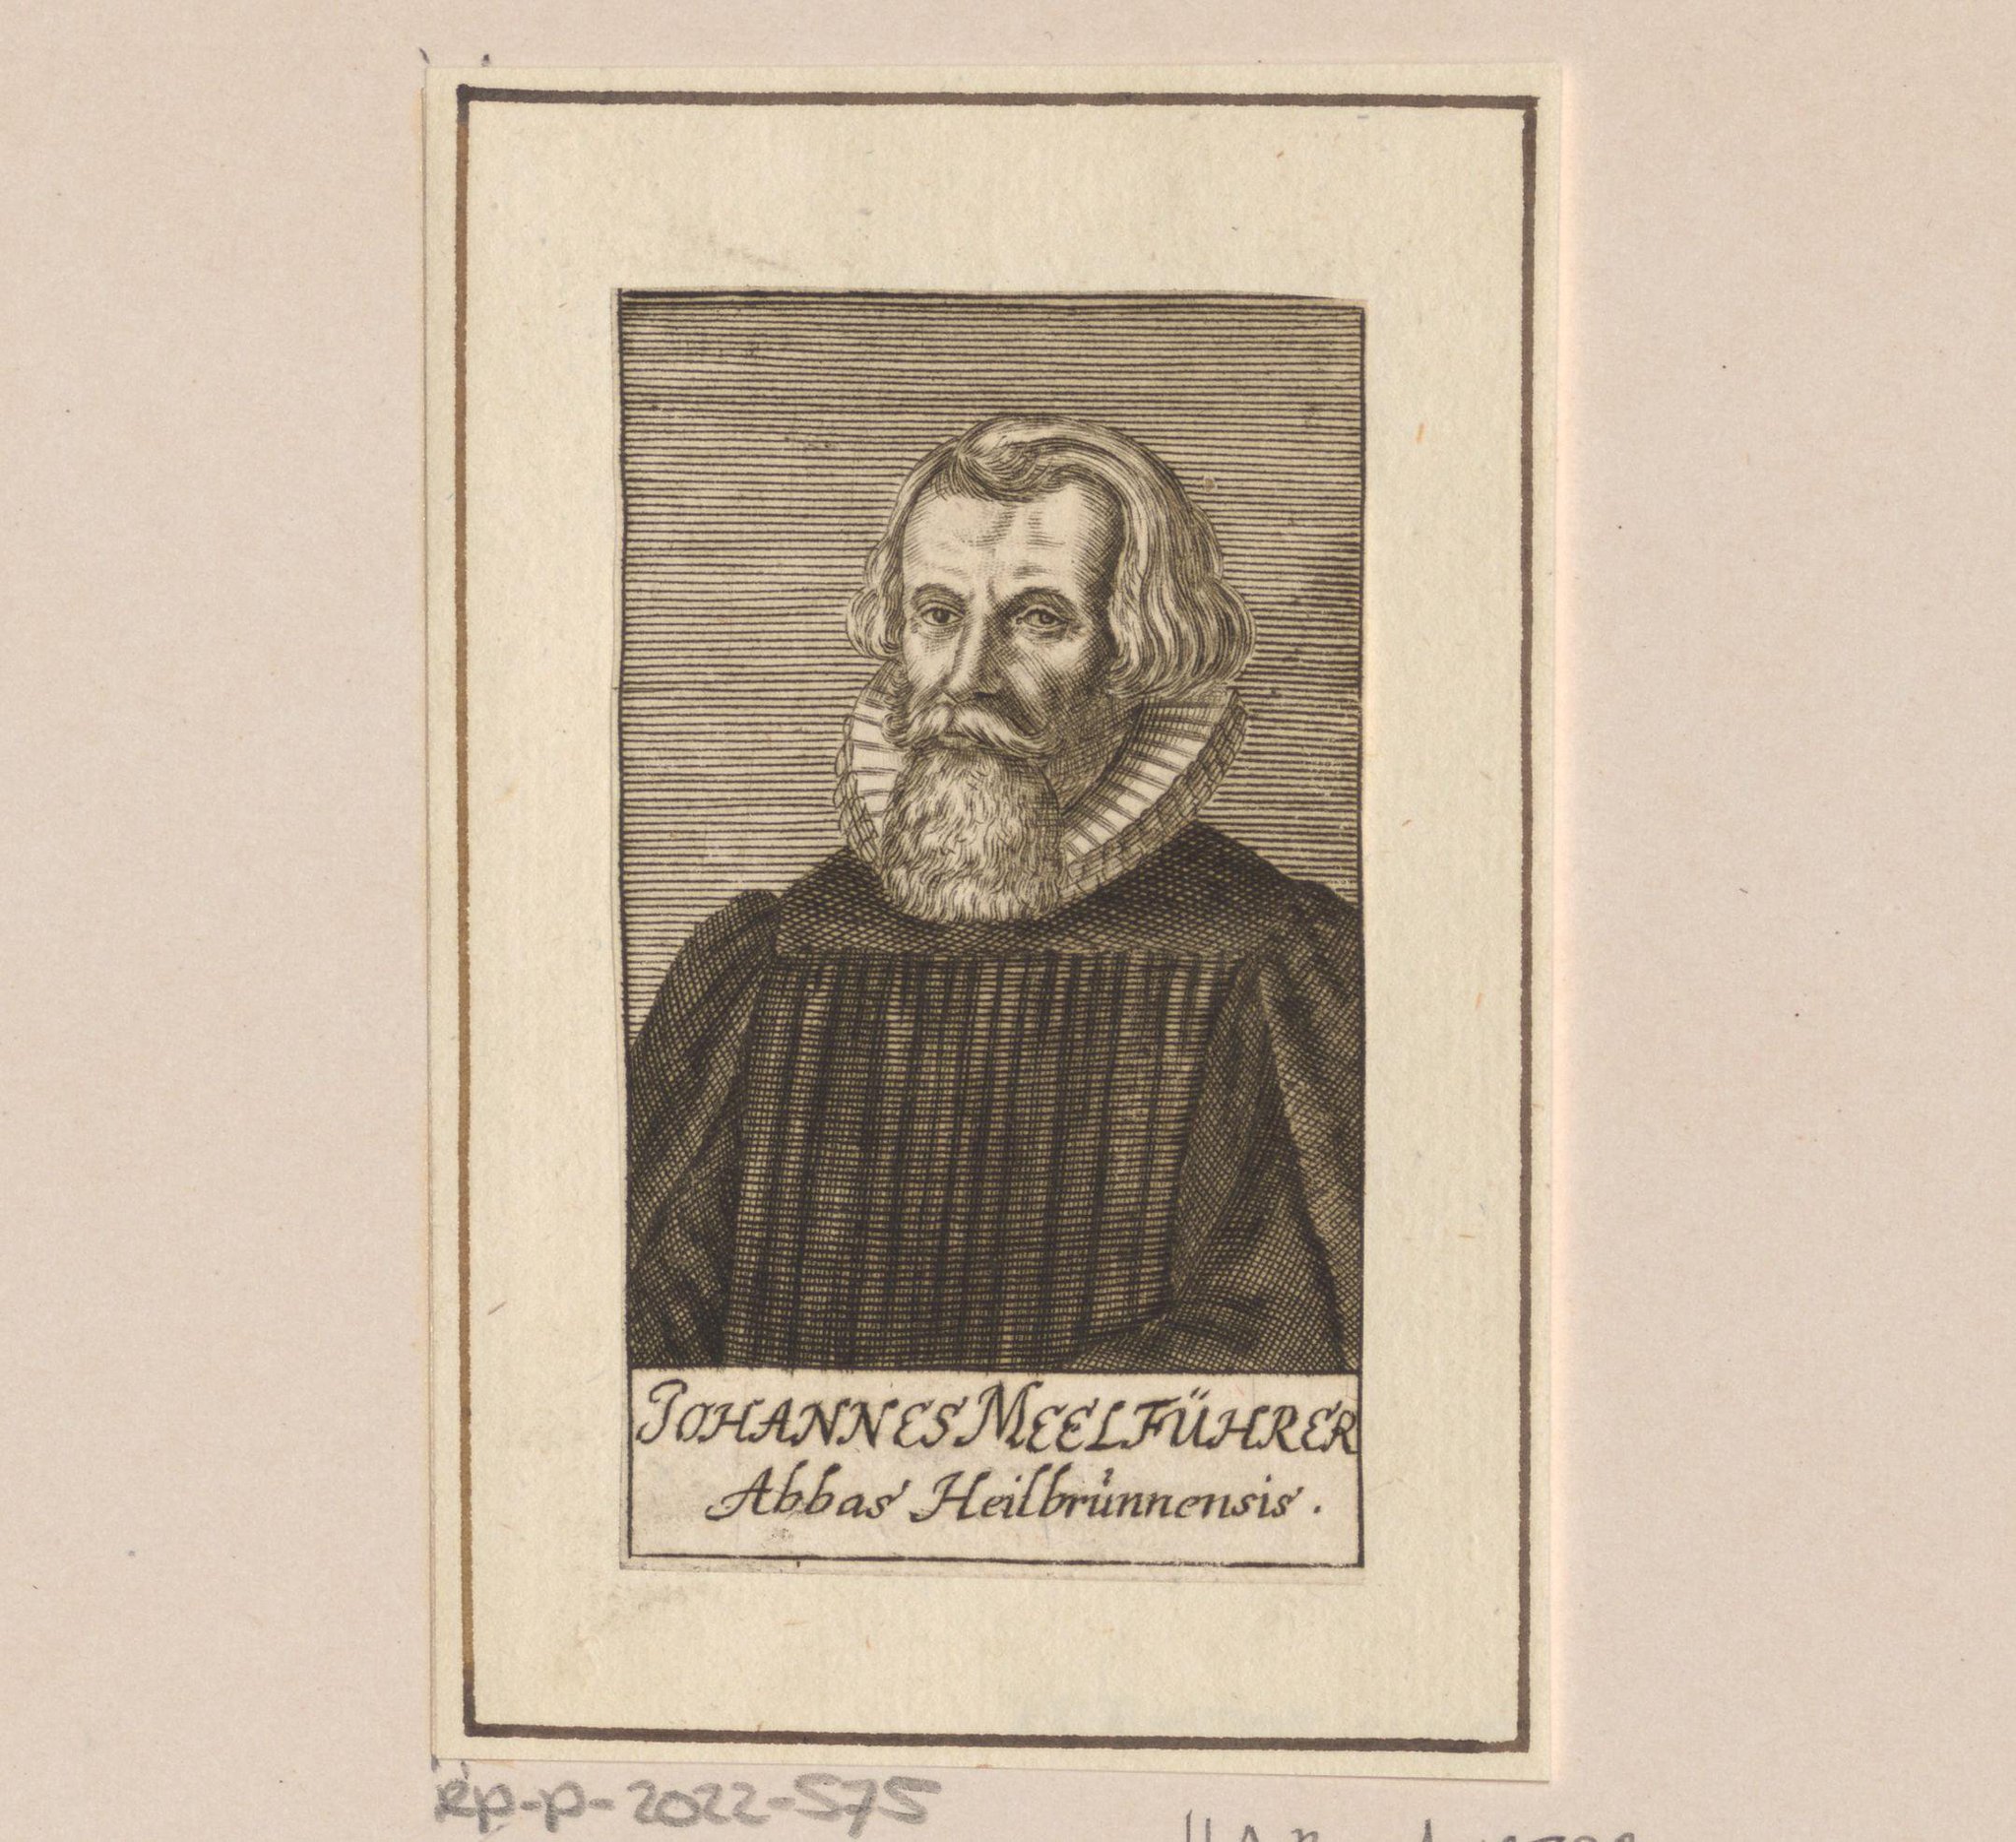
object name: book illustration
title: Portret van Johann Christoph Meelführer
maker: johann azelt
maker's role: print maker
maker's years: 1654-1692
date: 1688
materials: paper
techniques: engraving, etching, snipping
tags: johann christoph meelführer, historical persons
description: Prent waarschijnlijk uit: Freher, Paul. Theatrum virorum eruditione clarorum. Neurenberg: Johann Hoffmann, 1688.